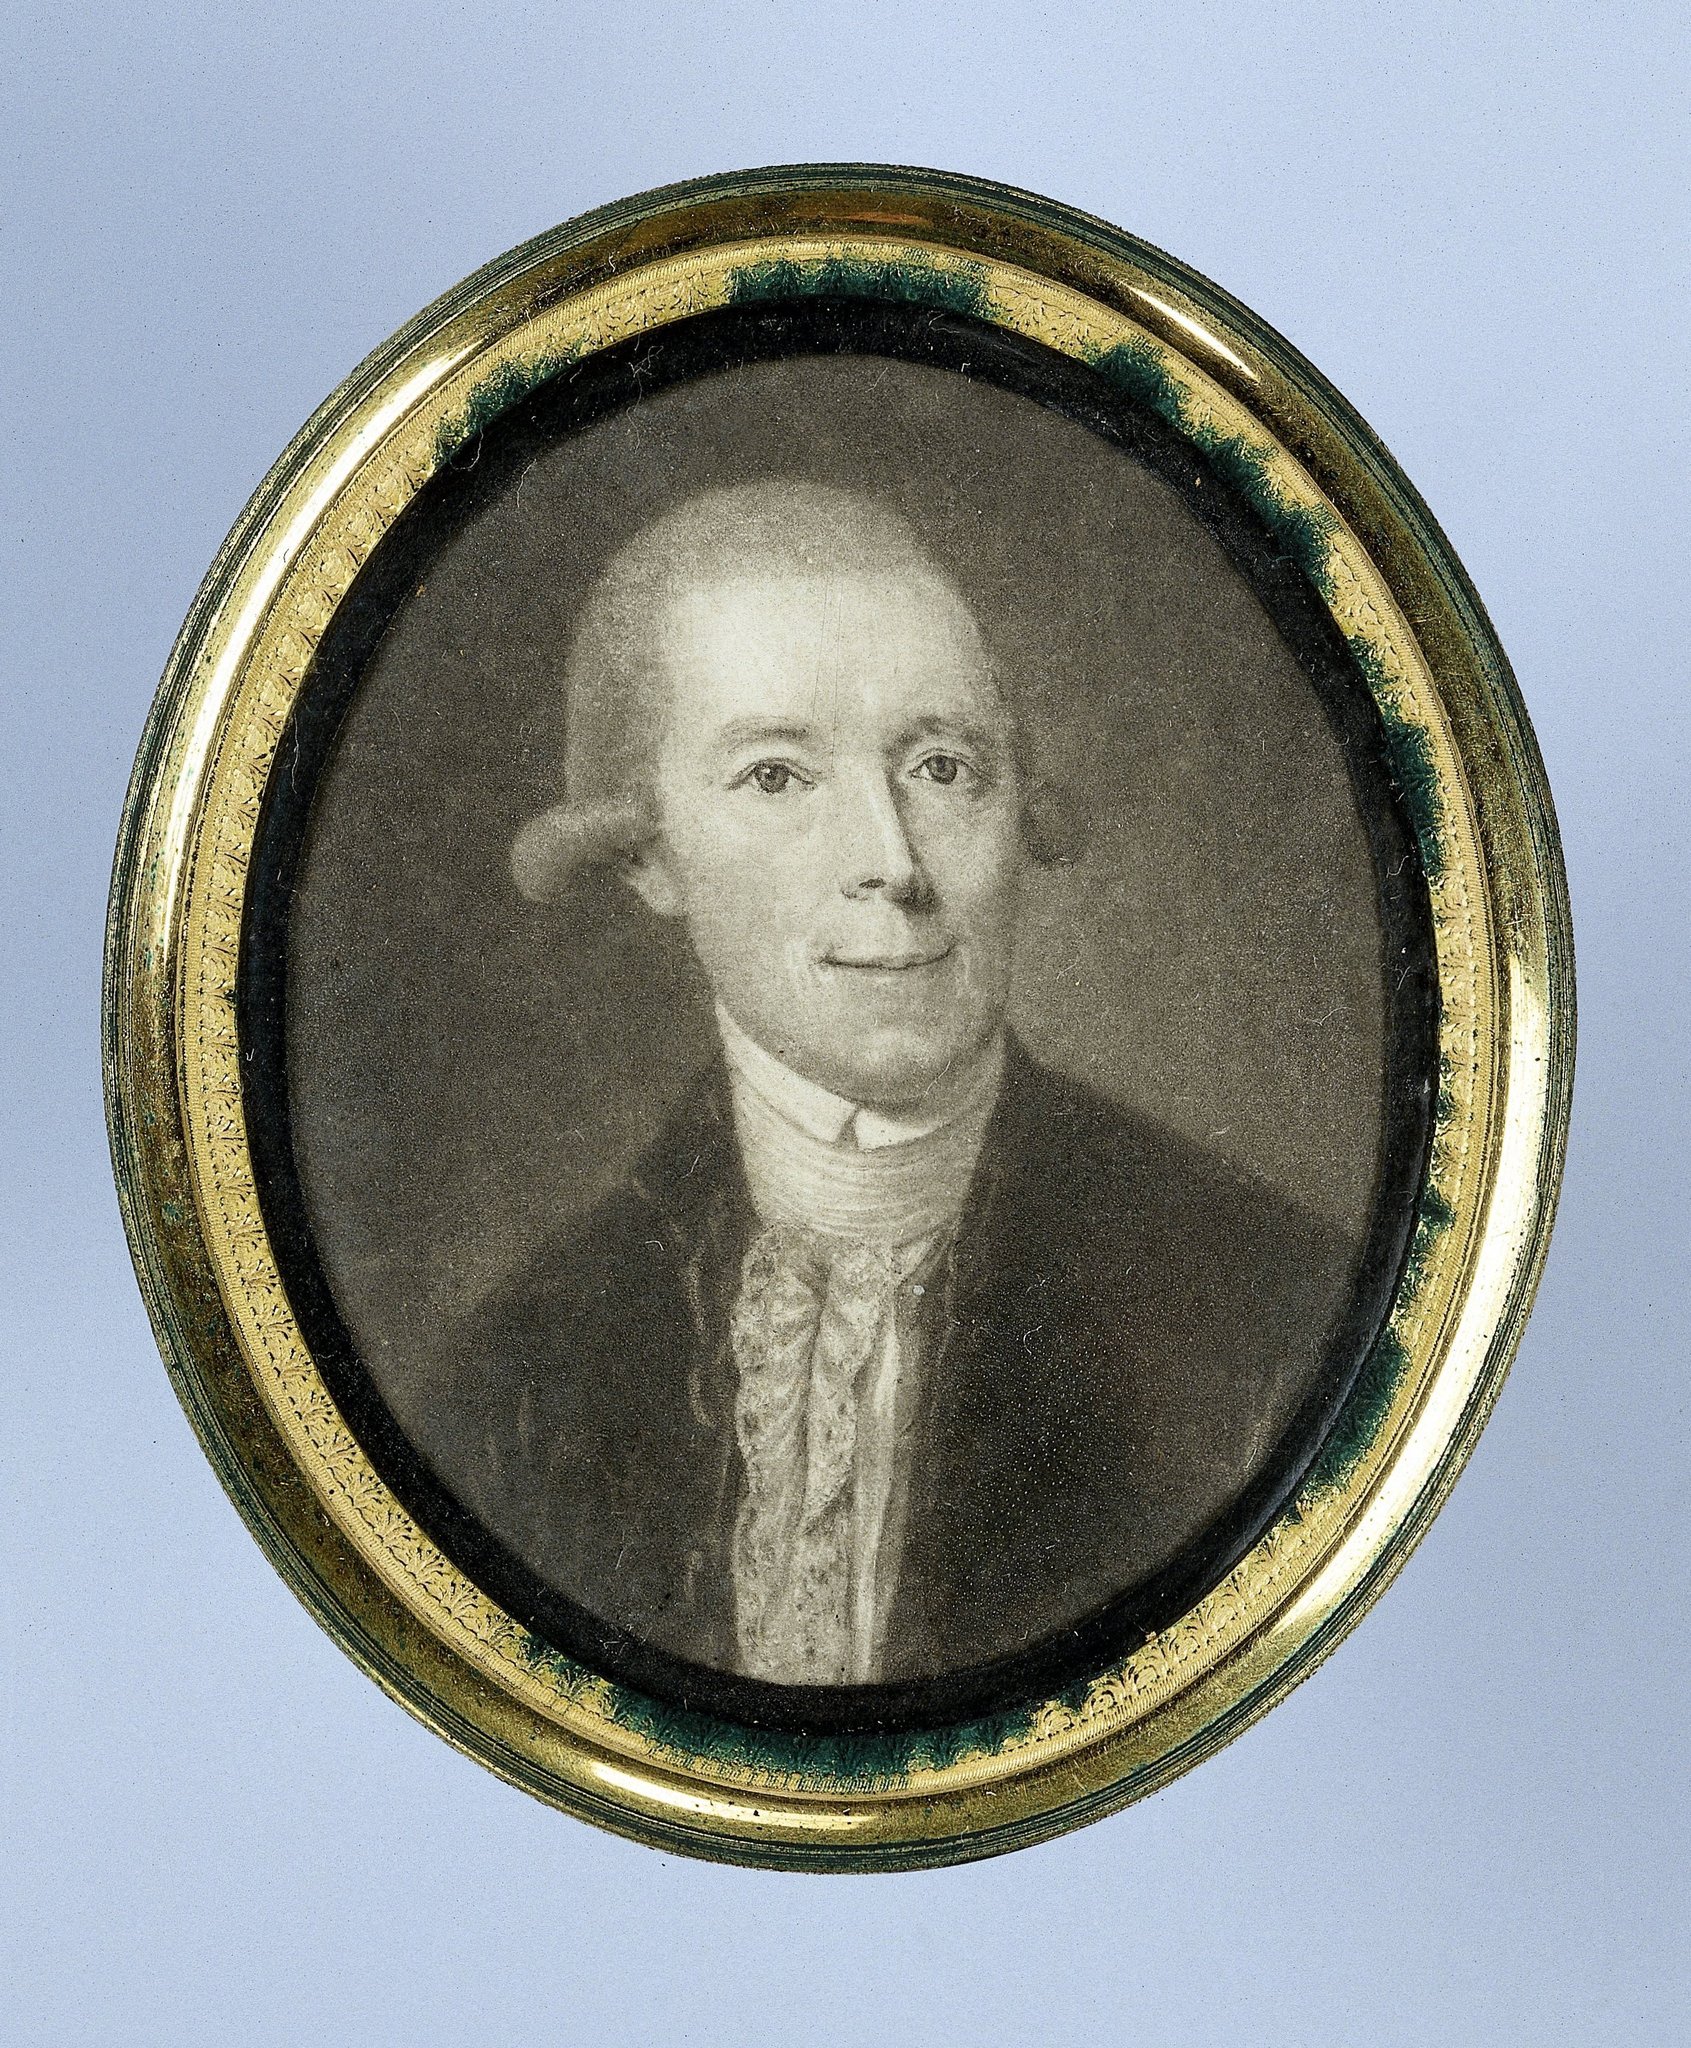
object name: frame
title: Portret van Joan Derk van der Capellen tot den Pol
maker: johan antonie kaldenbach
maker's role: draughtsman, print maker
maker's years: 1760-1818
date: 1784-1800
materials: glass, metal, paper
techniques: mezzotint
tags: politician, joan derk van der capellen tot den pol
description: Portretmedaillon J.D. van der Capellen, door J.A. Kaldenbach, ca. 1784.